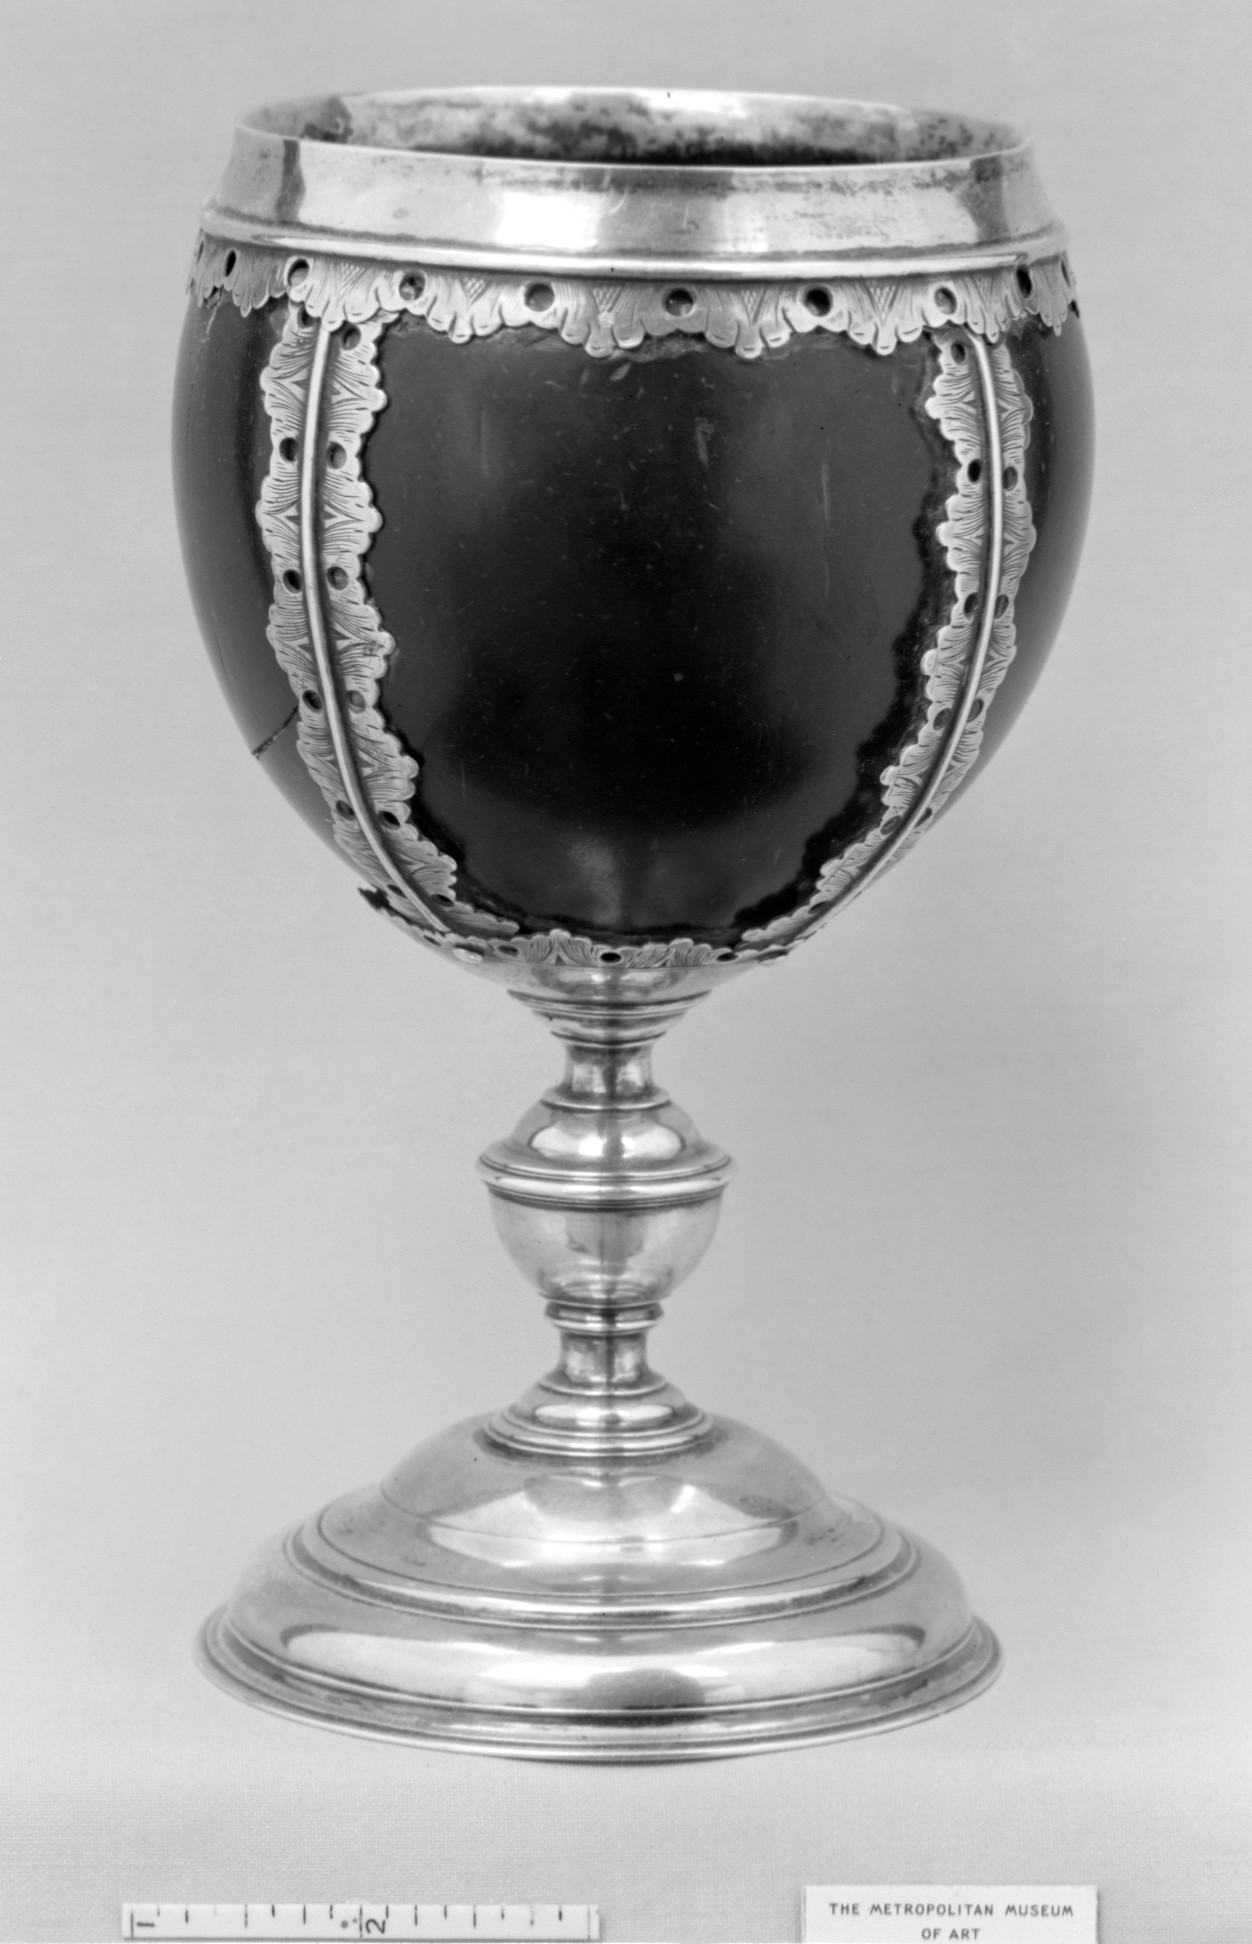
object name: cup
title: Coconut cup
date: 1601-1800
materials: silver